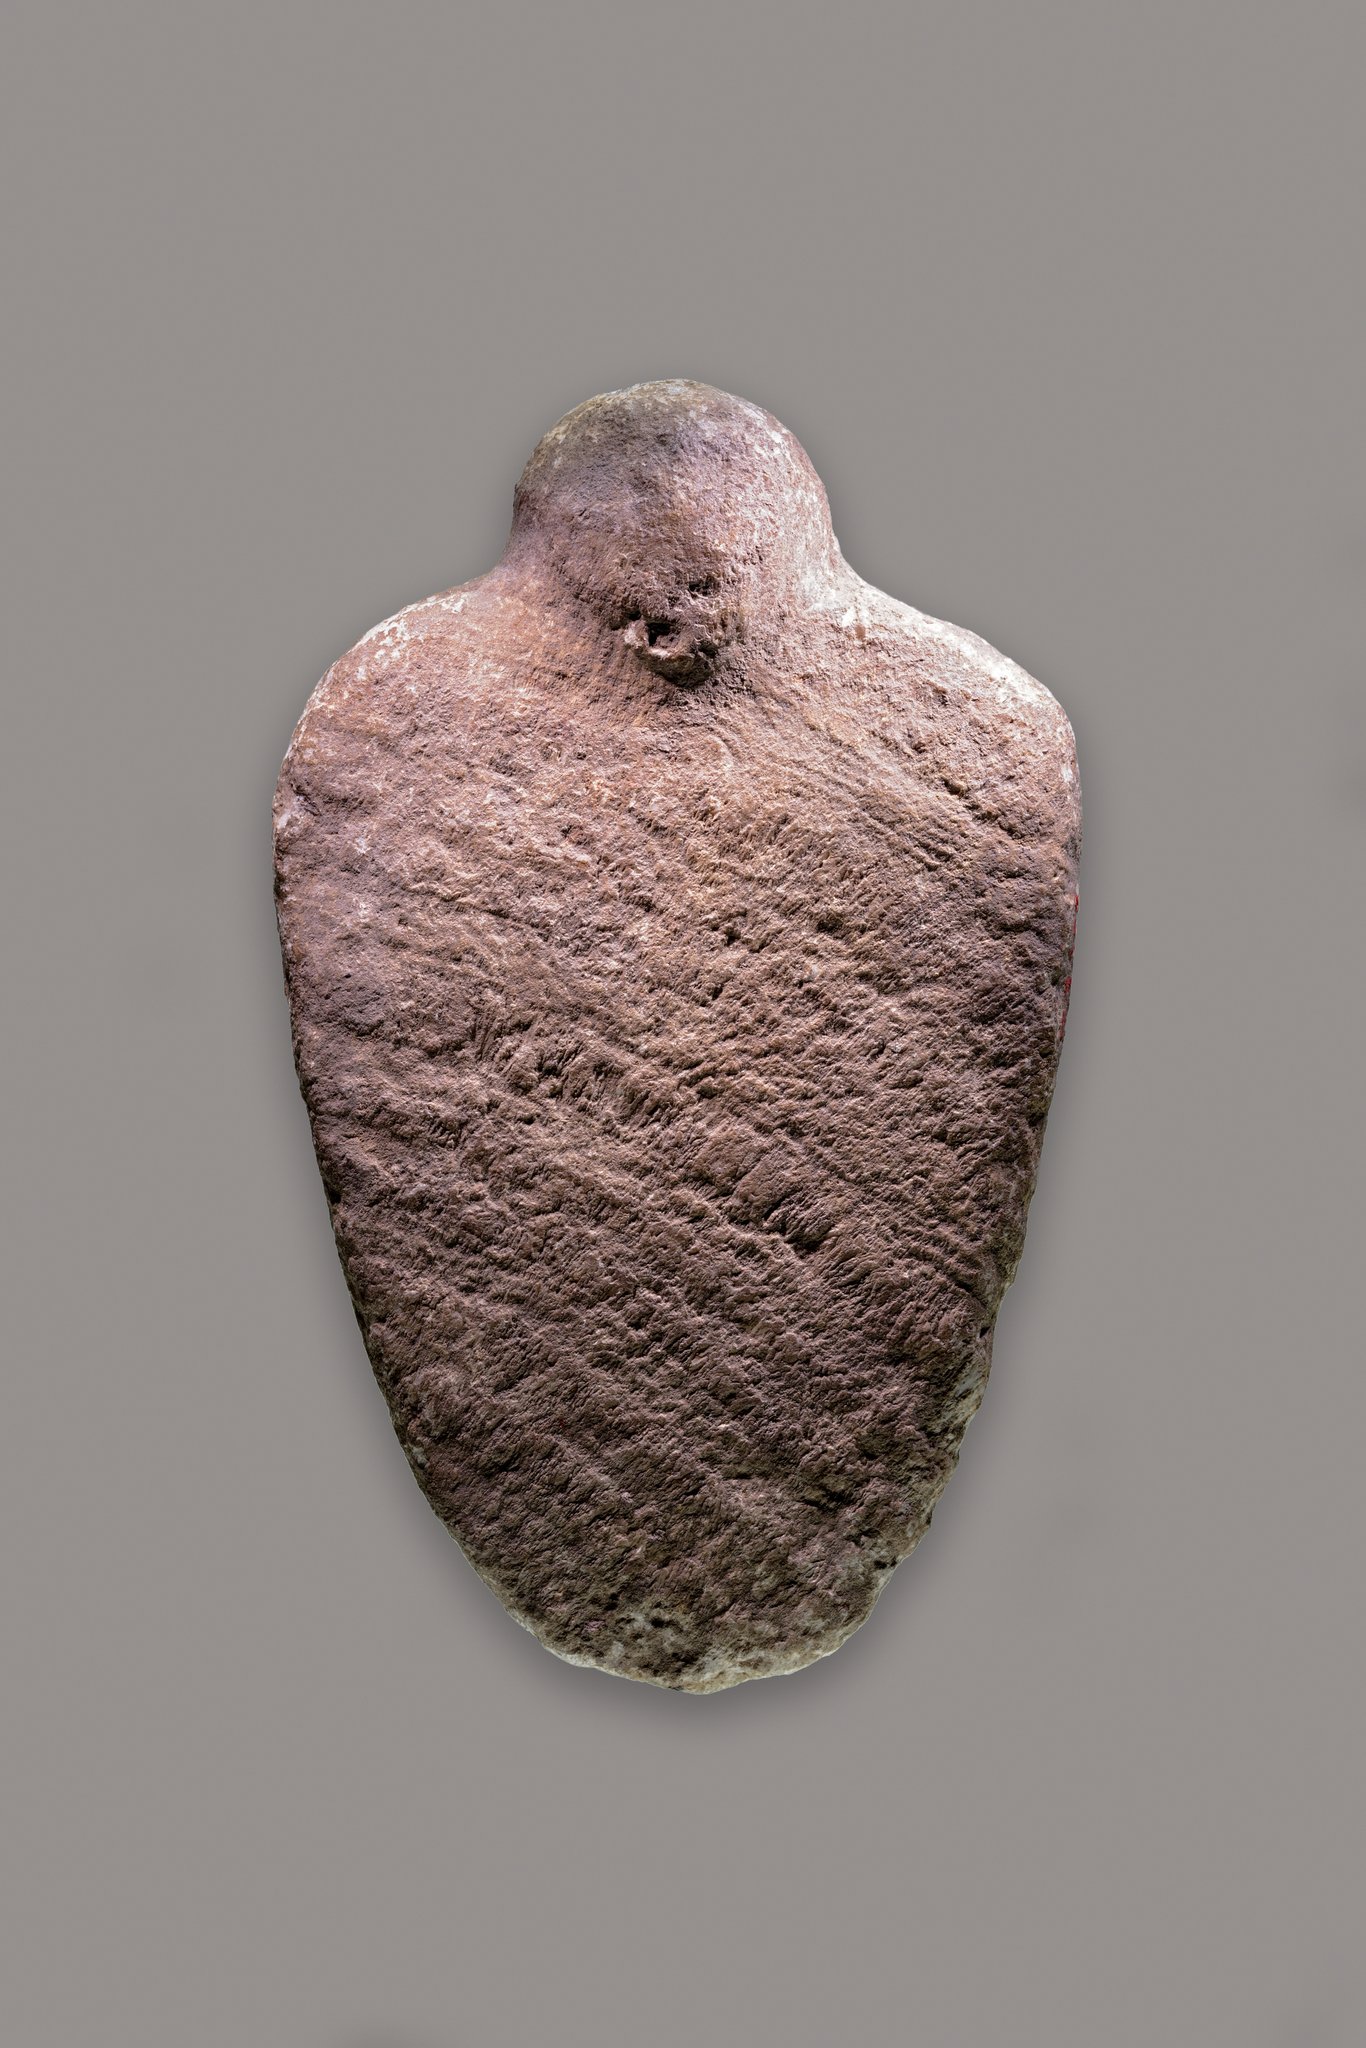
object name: figurine of foreigner, magical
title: Magical figurine of foreigner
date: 1981-1650 BCE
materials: stone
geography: egypt